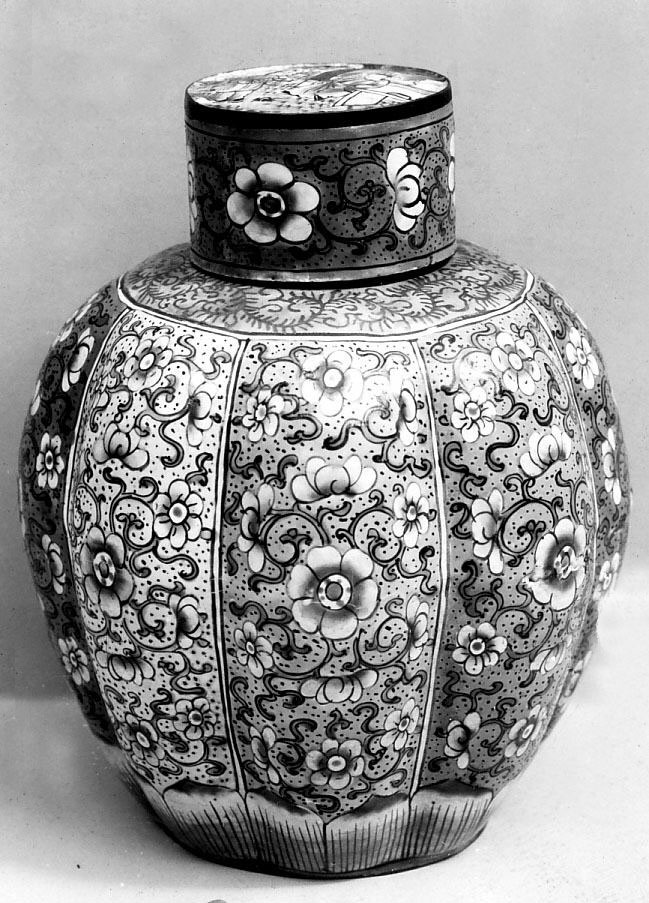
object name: tea caddy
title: Covered Tea Caddy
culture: chinese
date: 1701-1900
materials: enamel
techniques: painting